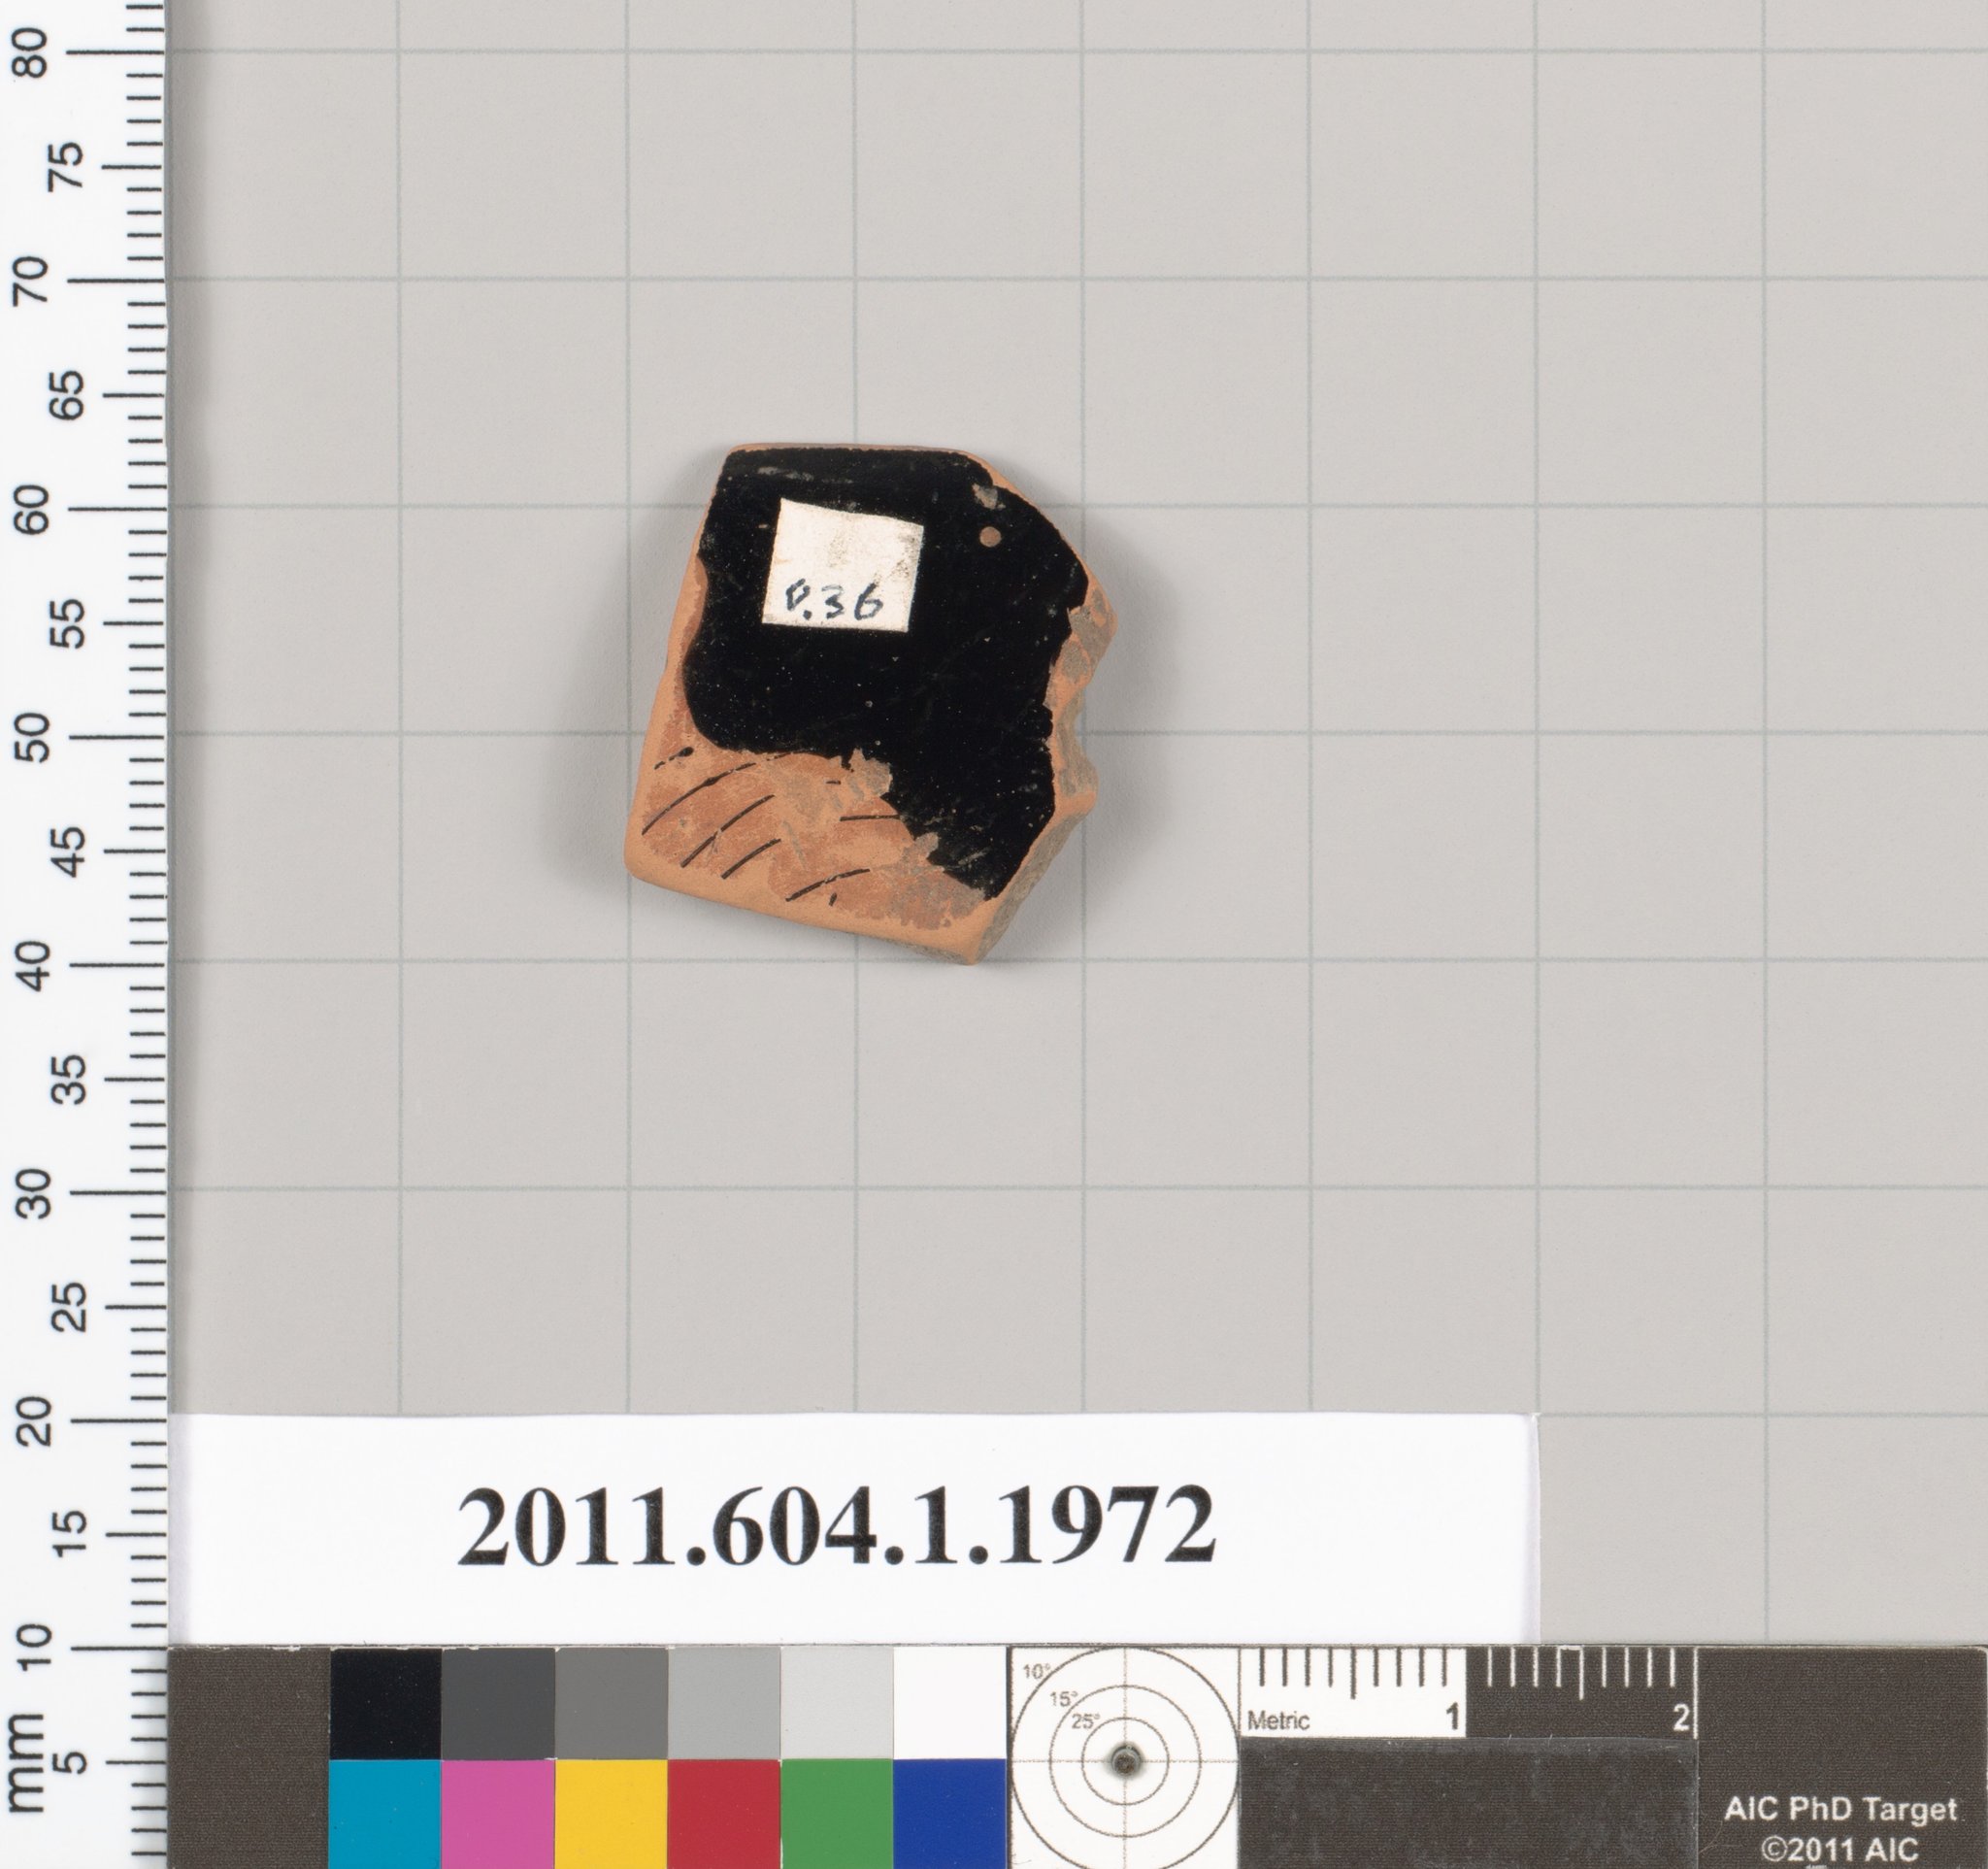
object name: kylix fragment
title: Terracotta rim fragment of a kylix (drinking cup)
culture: greek, attic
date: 475-451 BCE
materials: terracotta